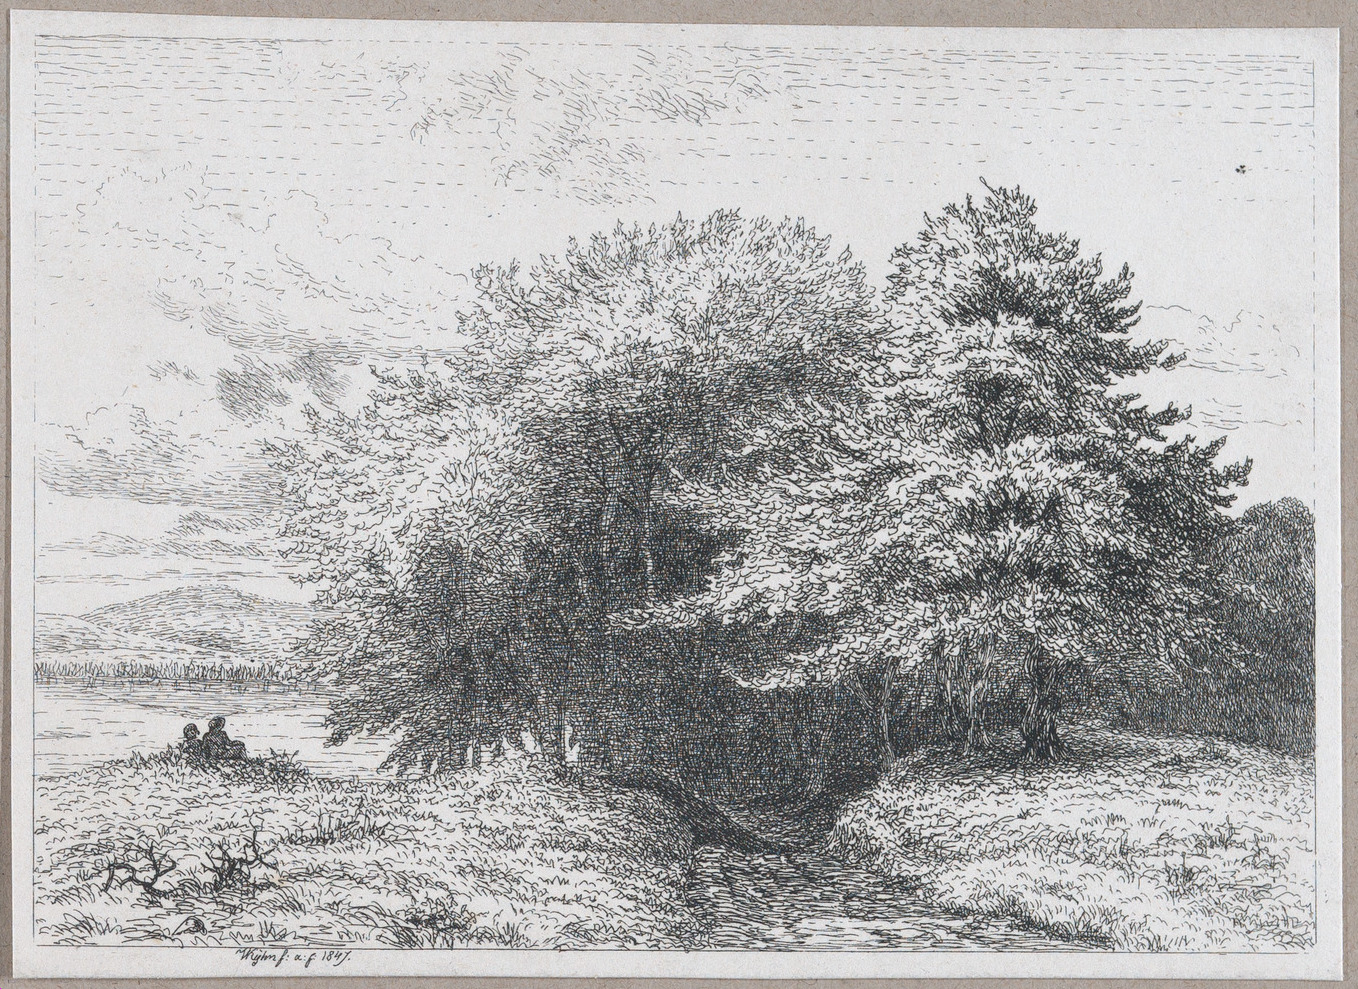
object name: print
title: Rural View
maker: peter vilhelm carl kyhn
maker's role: artist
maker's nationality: danish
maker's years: 1819-1903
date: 1847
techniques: etching